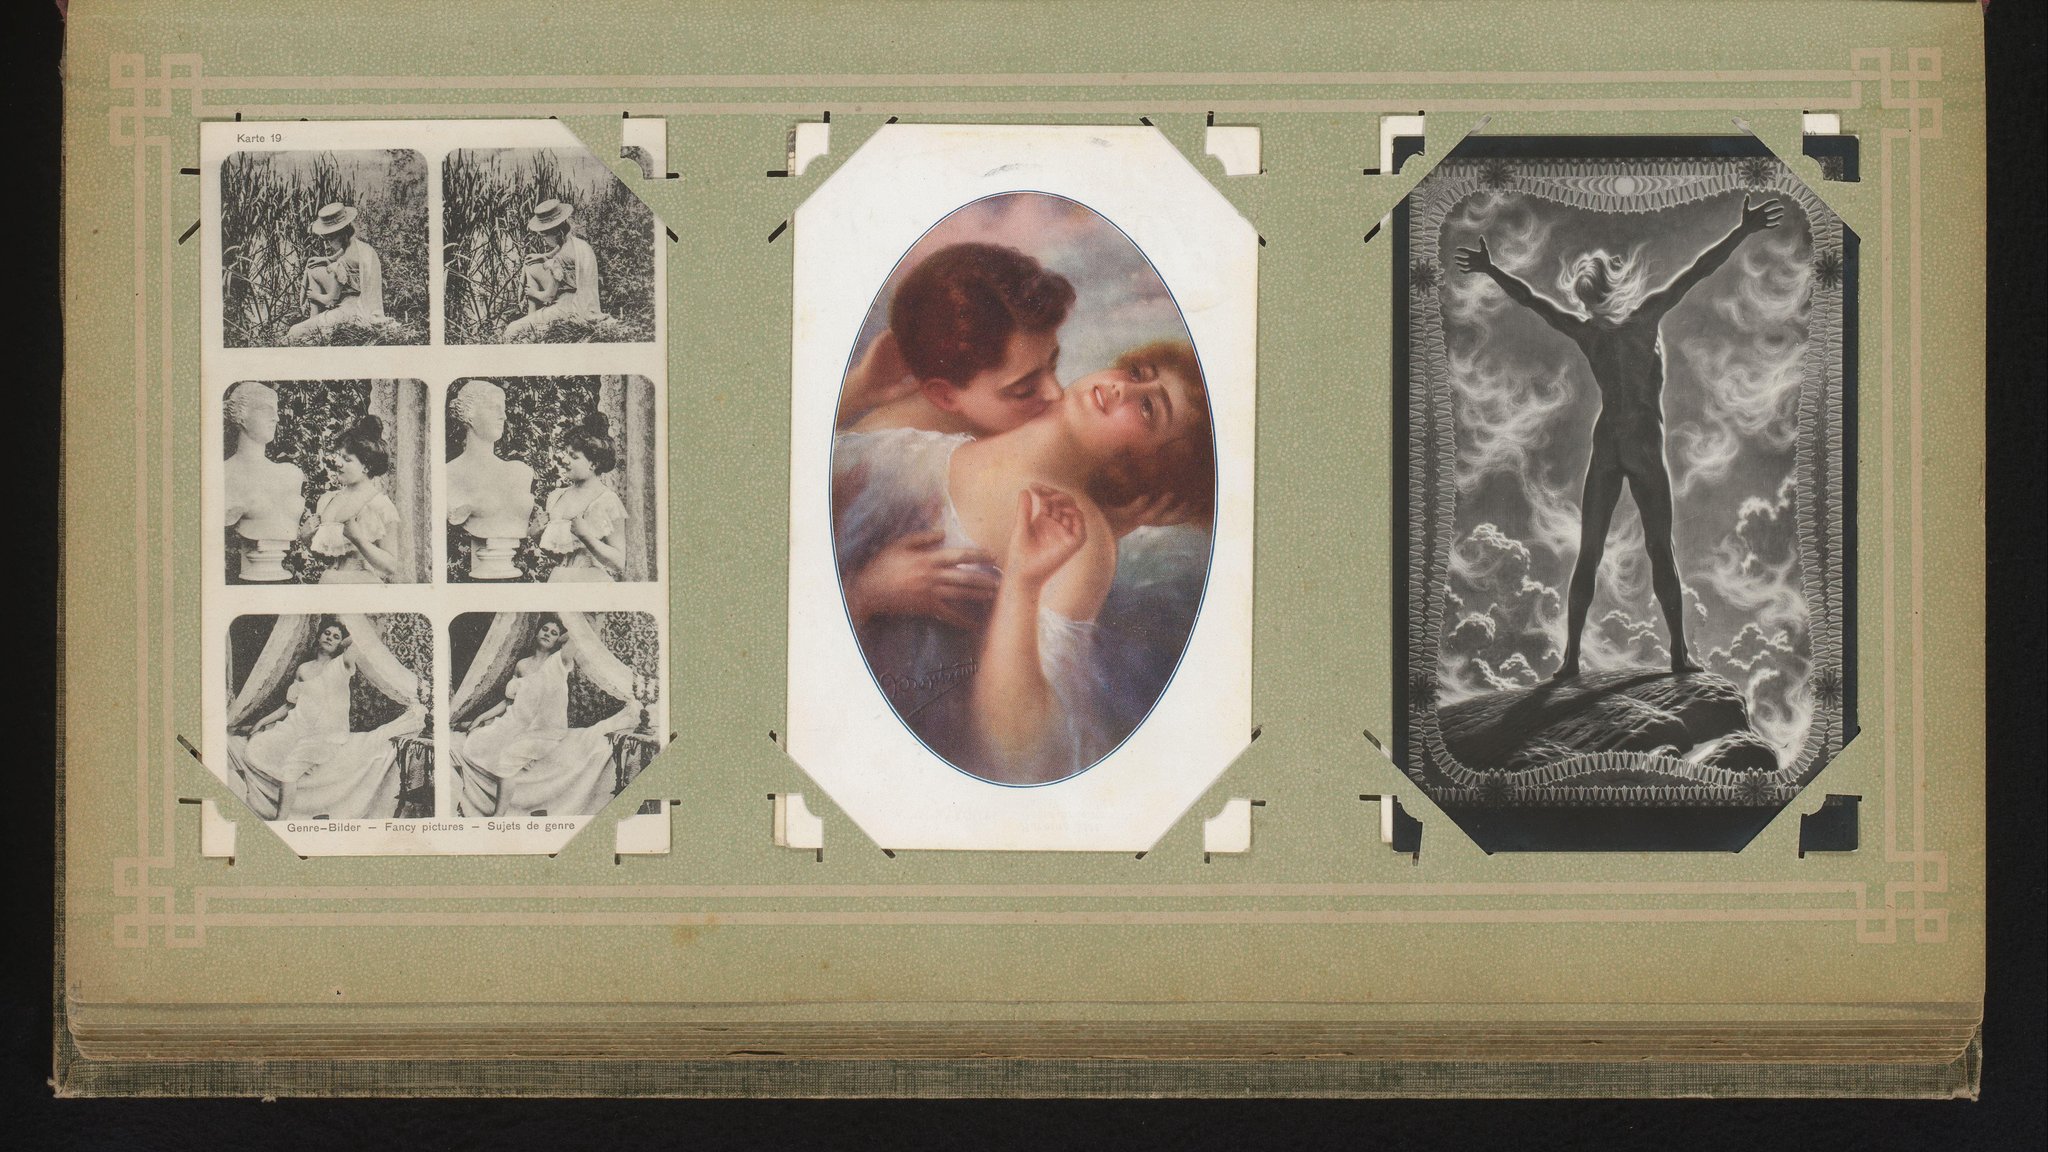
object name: reproduction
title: Twee reproducties van schilderijen en zes afbeeldingen van een jonge vrouw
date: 1900-1930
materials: cardboard, photographic support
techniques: photograph, gelatin silver print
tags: historical persons - bb - woman, historical persons, couple of lovers, man (showing himself) undressed, quasi-nude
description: Drie maal twee stereo beelden van een jonge vrouw, een reproductie van een schilderij van een paar geliefden en fotoreproductie van geschilderd portret van een naakt man, op de rug gezien. Deze foto en prenten maken deel uit van een album.